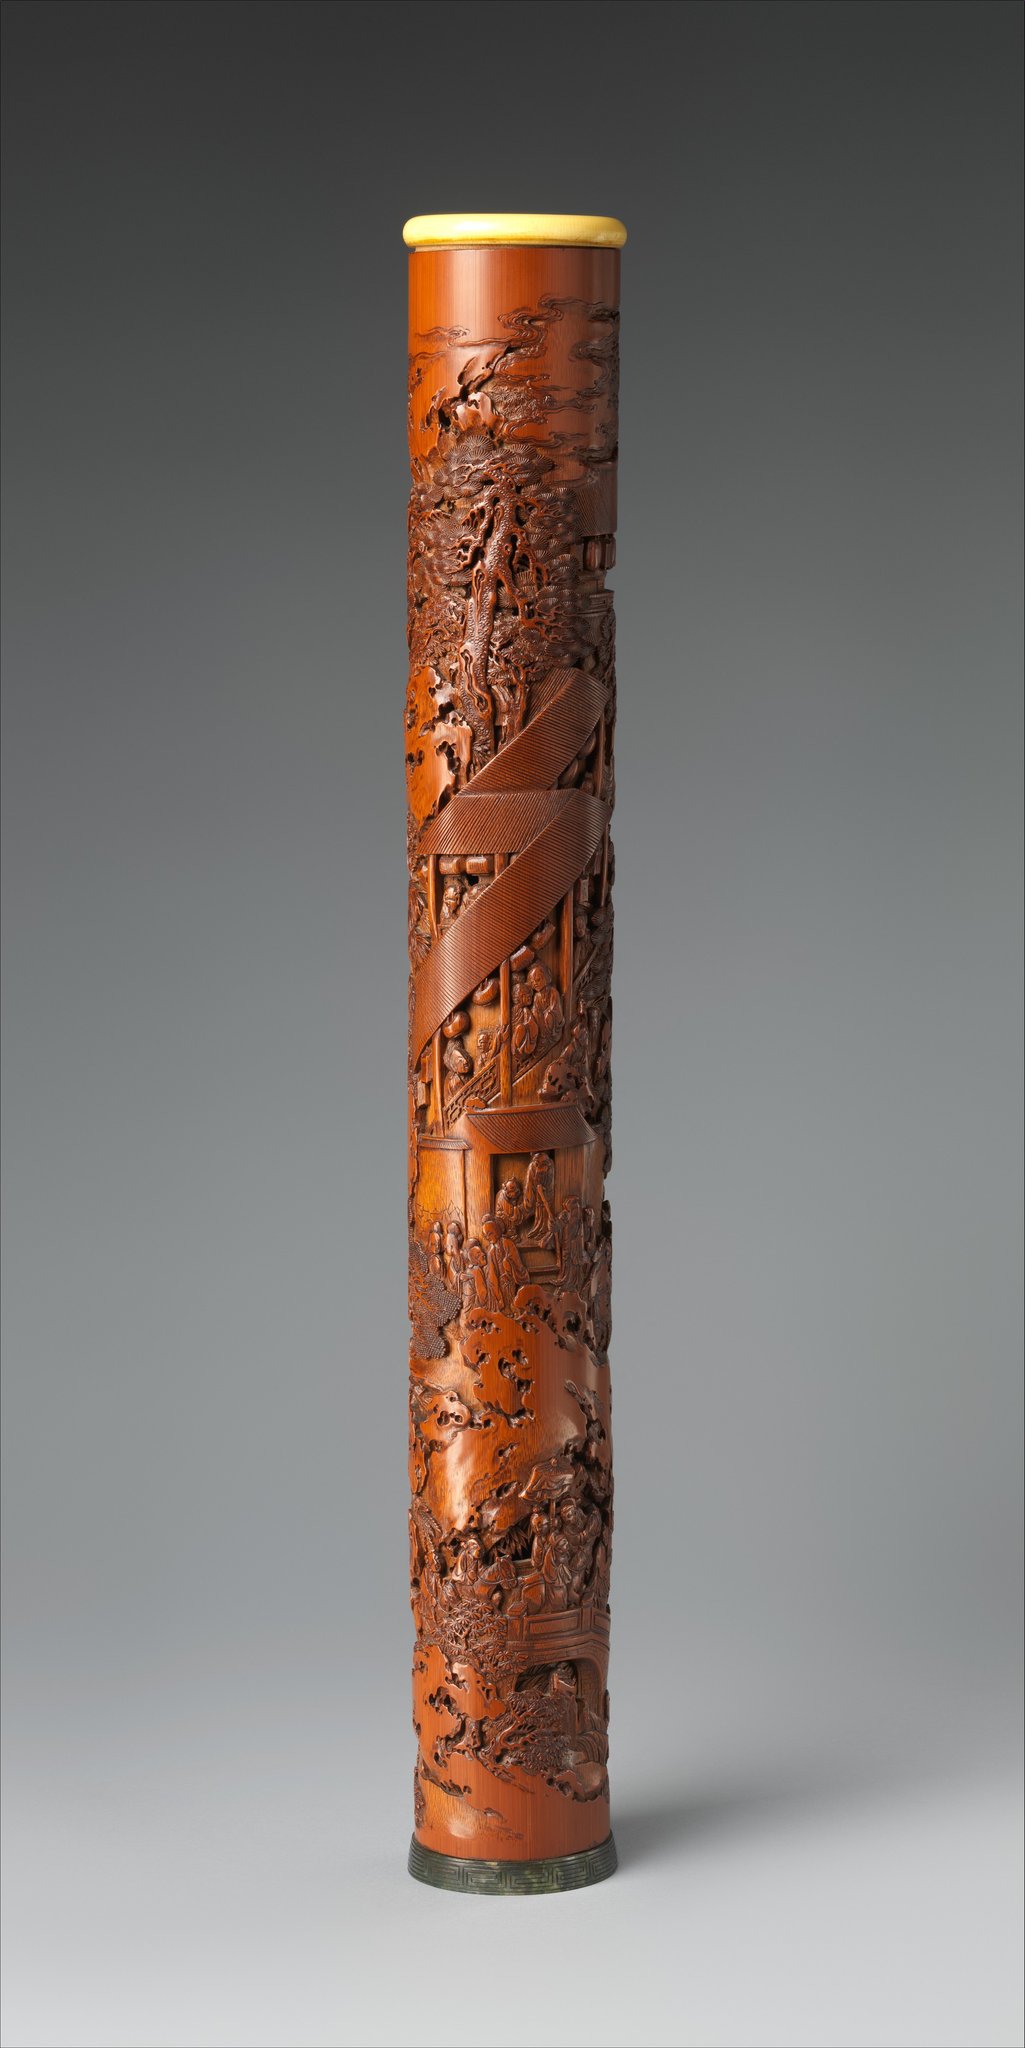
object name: incense holder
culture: chinese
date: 1701-1800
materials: bamboo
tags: human figures